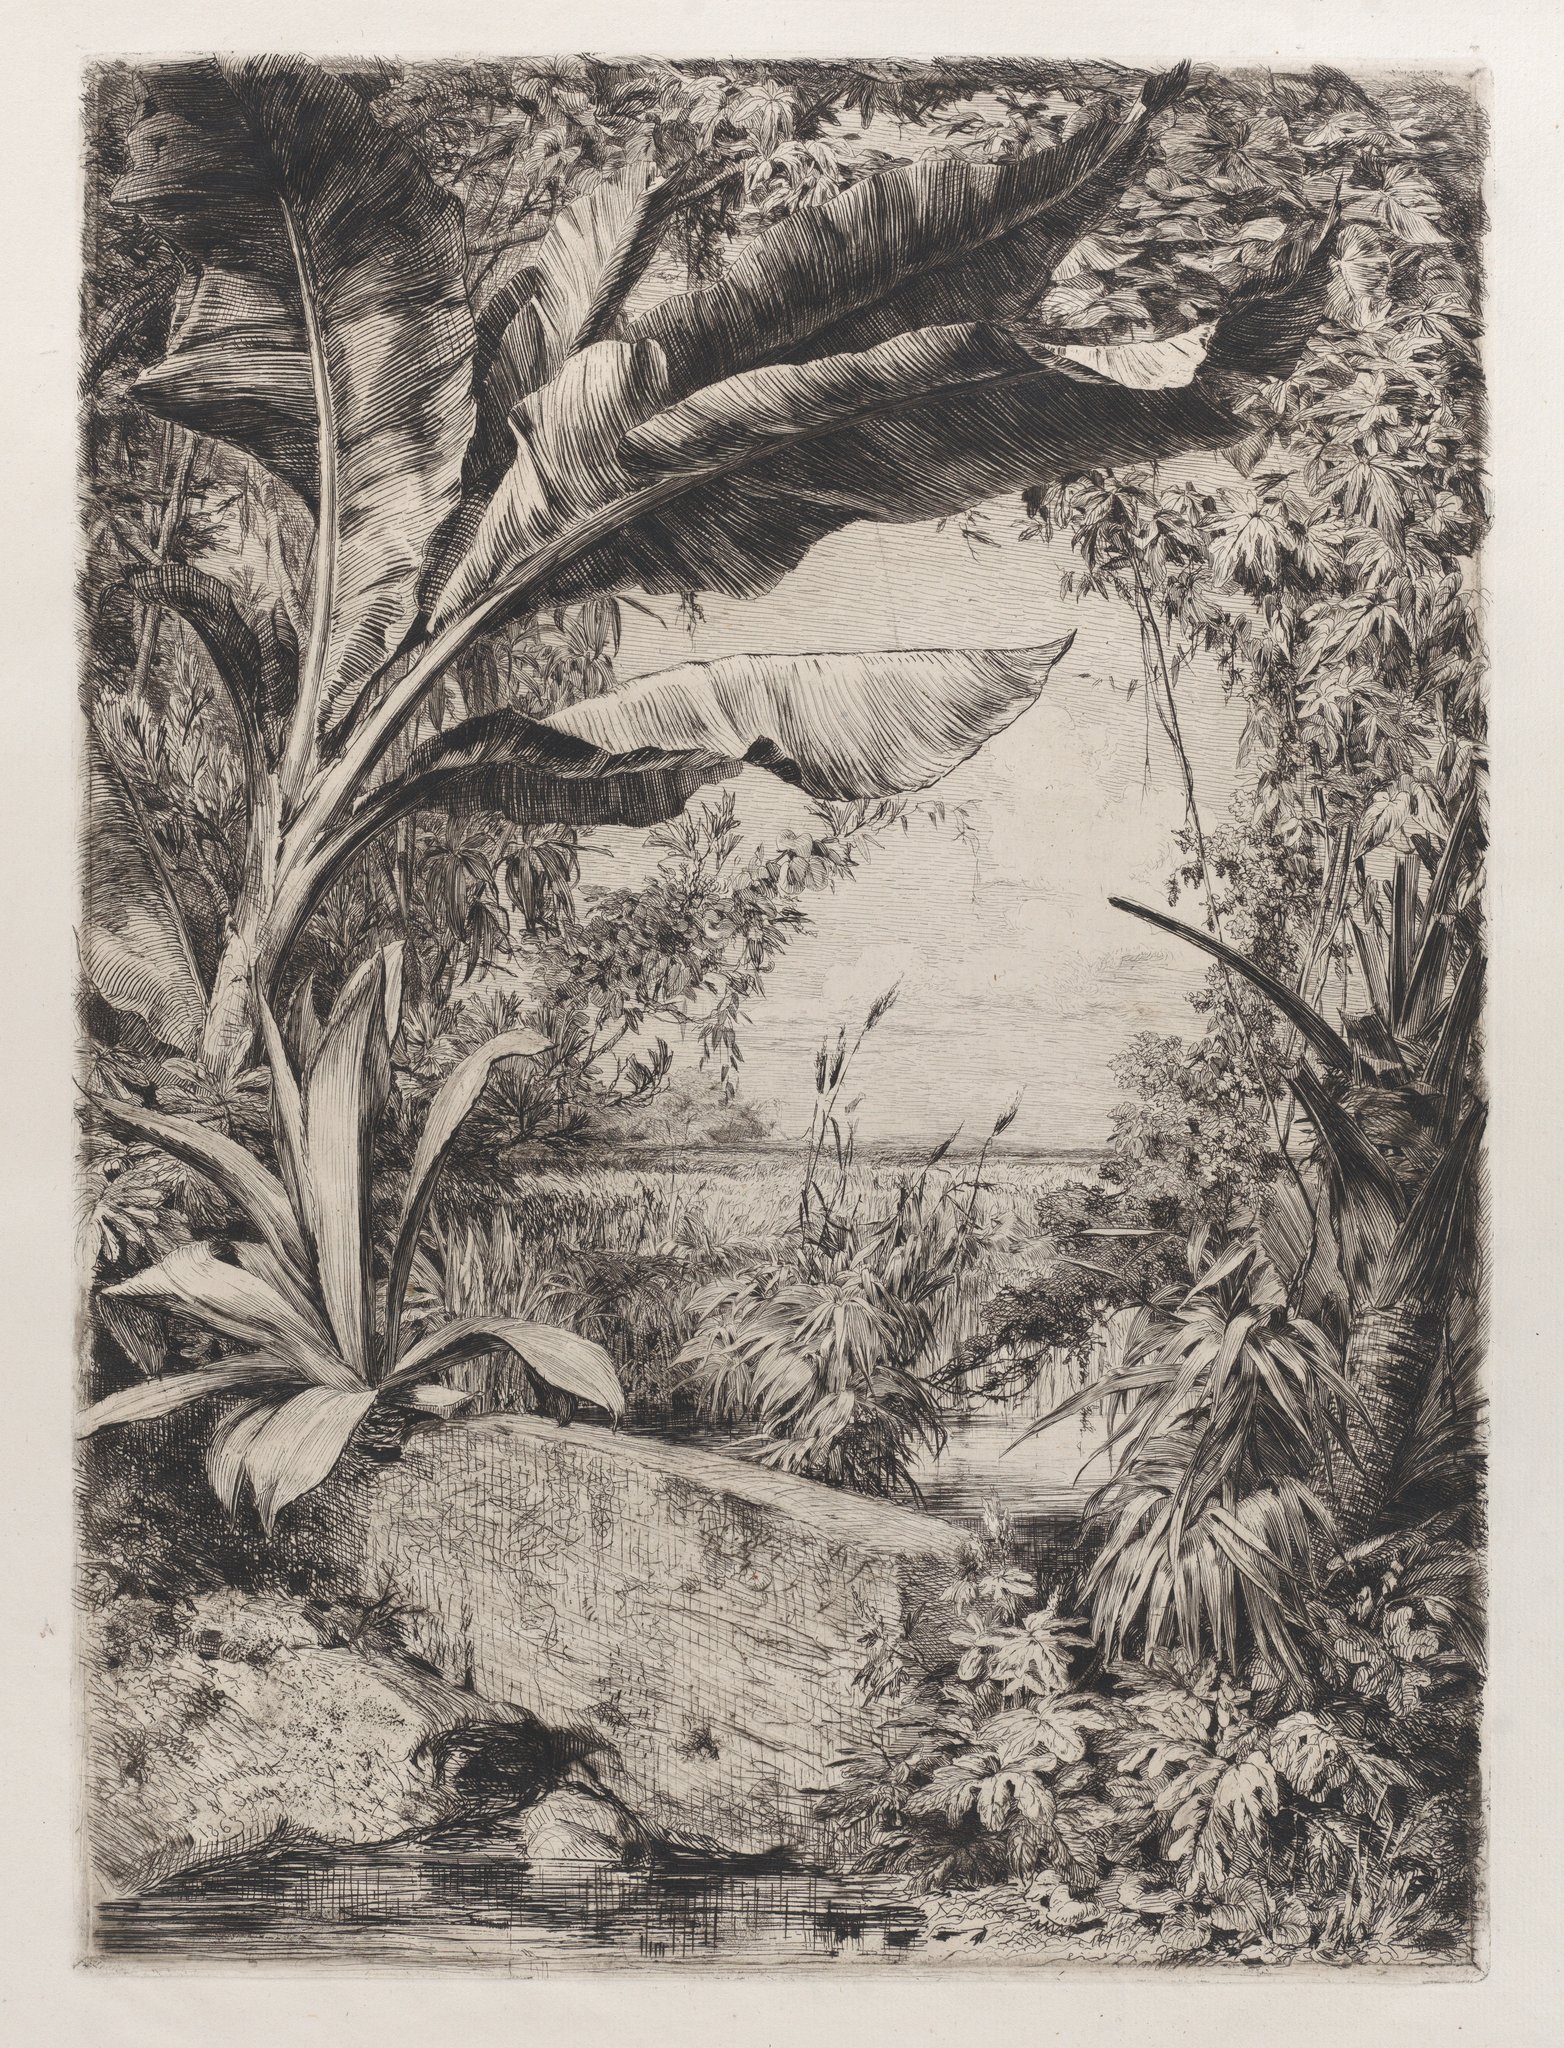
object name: print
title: Tropical Plants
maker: jules-ferdinand jacquemart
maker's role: artist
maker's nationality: french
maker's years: 1837-1880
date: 1863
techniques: etching